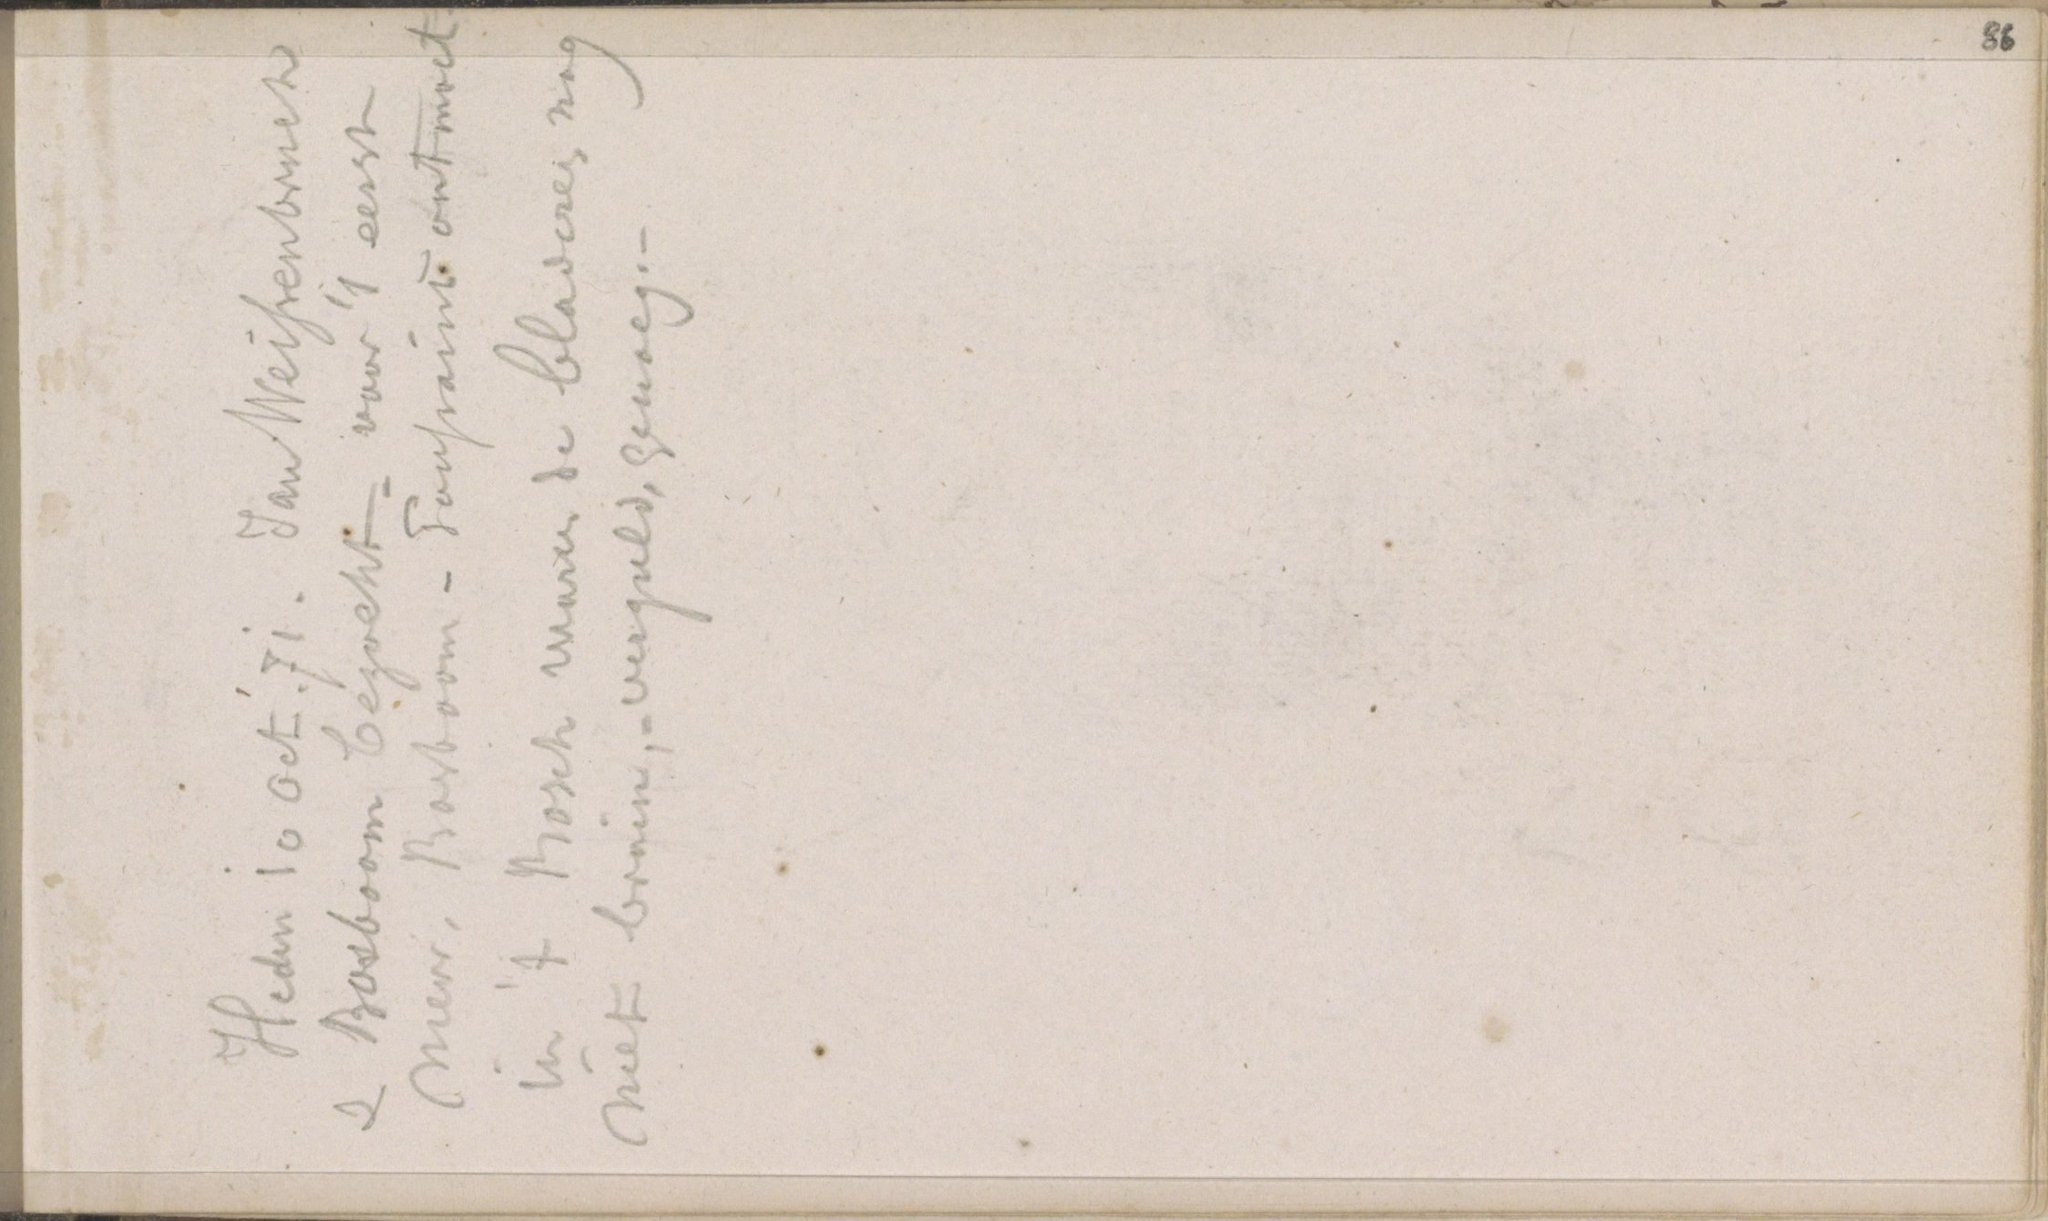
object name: sketchbook leaf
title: Notitie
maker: johannes tavenraat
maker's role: draughtsman, painter, print maker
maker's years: 1809-1881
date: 1810-1871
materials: paper, pencil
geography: the hague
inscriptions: date and inscription: ‘Heden 10 oct. '71. Jan Weissenbruch/ & Bosboom bezocht. voor 't eerst/ mevr. Bosboom-Toussaint ontmoet./ in 't Bosch waren de bladeren nog/ niet bruin, vergeeld, genoeg.-’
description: Blad 86 recto uit een schetsboek met 98 bladen.